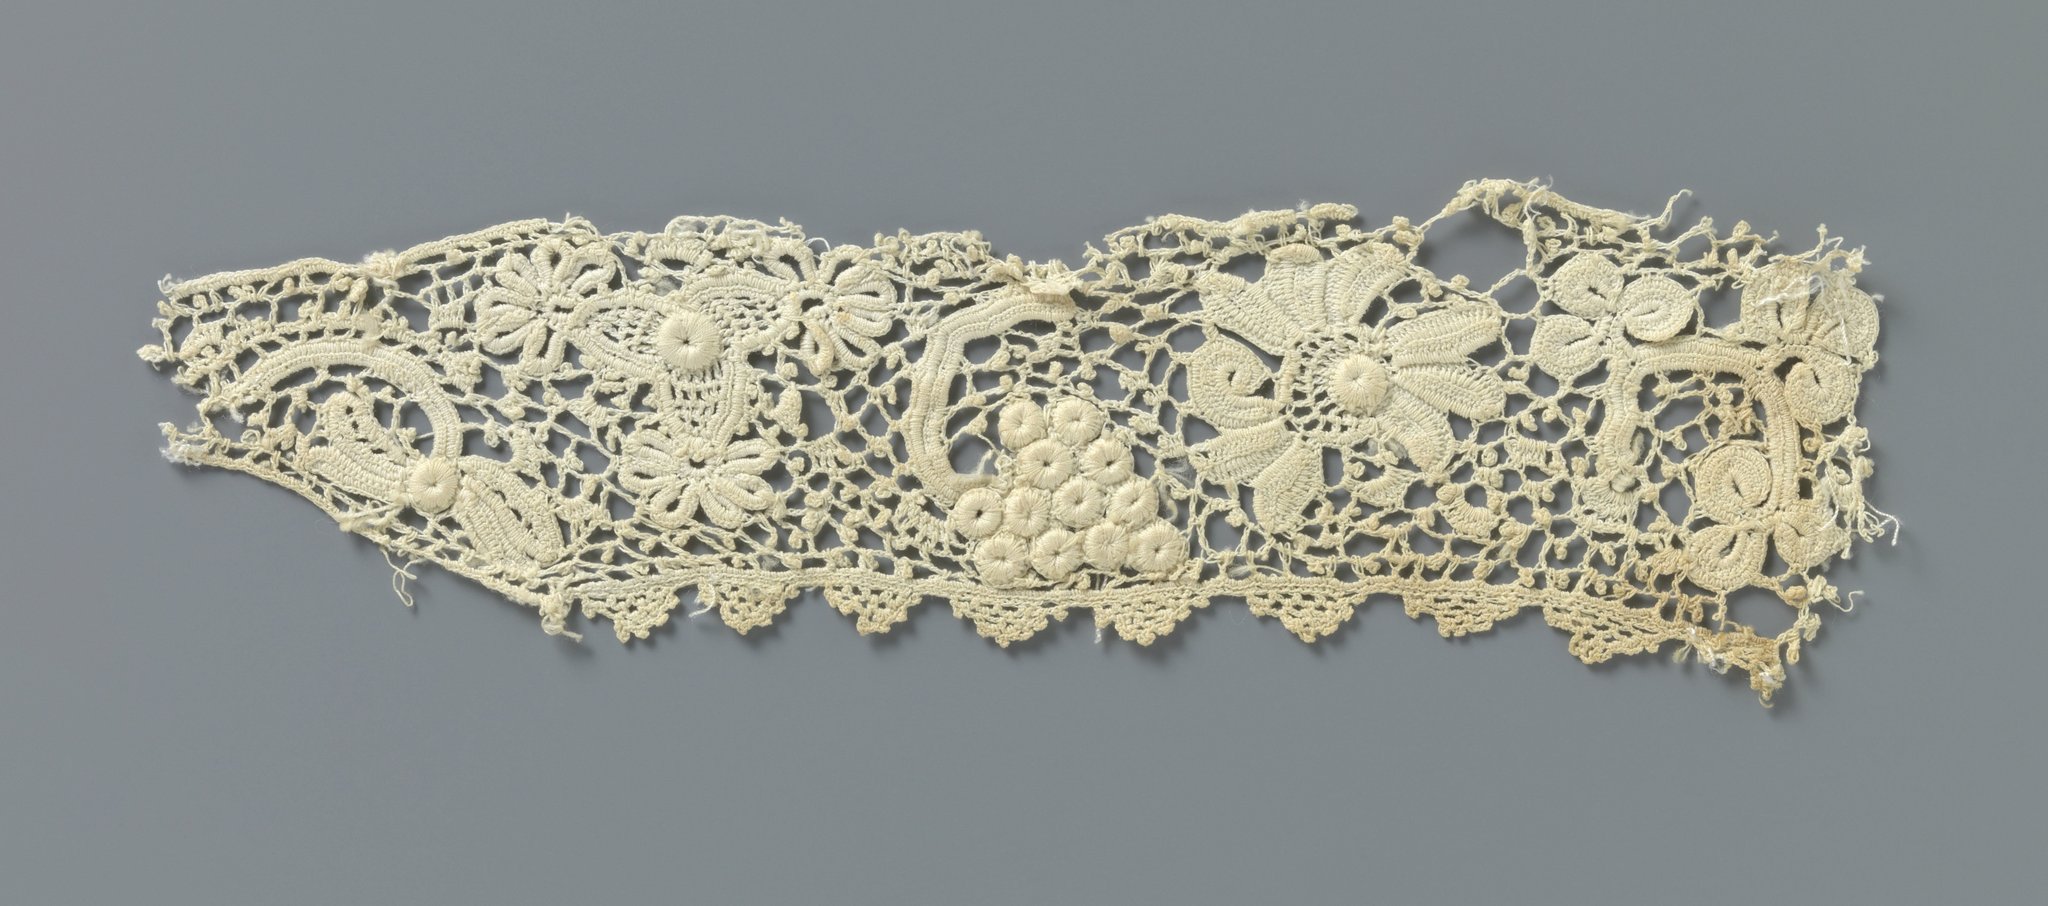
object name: strip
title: Strook gehaakte kant met bloemen en druiventros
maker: Anonymous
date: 1890-1909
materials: cotton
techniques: crocheted lace, irish crochet lace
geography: ireland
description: Het is een aanname dat deze Ierse gehaakte kant ook daadwerkelijk in Ierland is gemaakt. Ierse gehaakte kant kent zijn oorsprong rond 1760 en kwam vanaf 1840 in ontwikkeling. Aangezien volgens Martine Bruggeman (Kant in Europa) de Ierse haakindustrie aan het eind van de 19e eeuw gereorganiseerd werd en in populariteit groeide, is het hier beschreven stuk gedateerd rond 1890, tot 1909 vanwege de datering in het eerste decennium van populariteit van Ierse gehaakte kant volgens het Kantlexicon (Johan Coene).